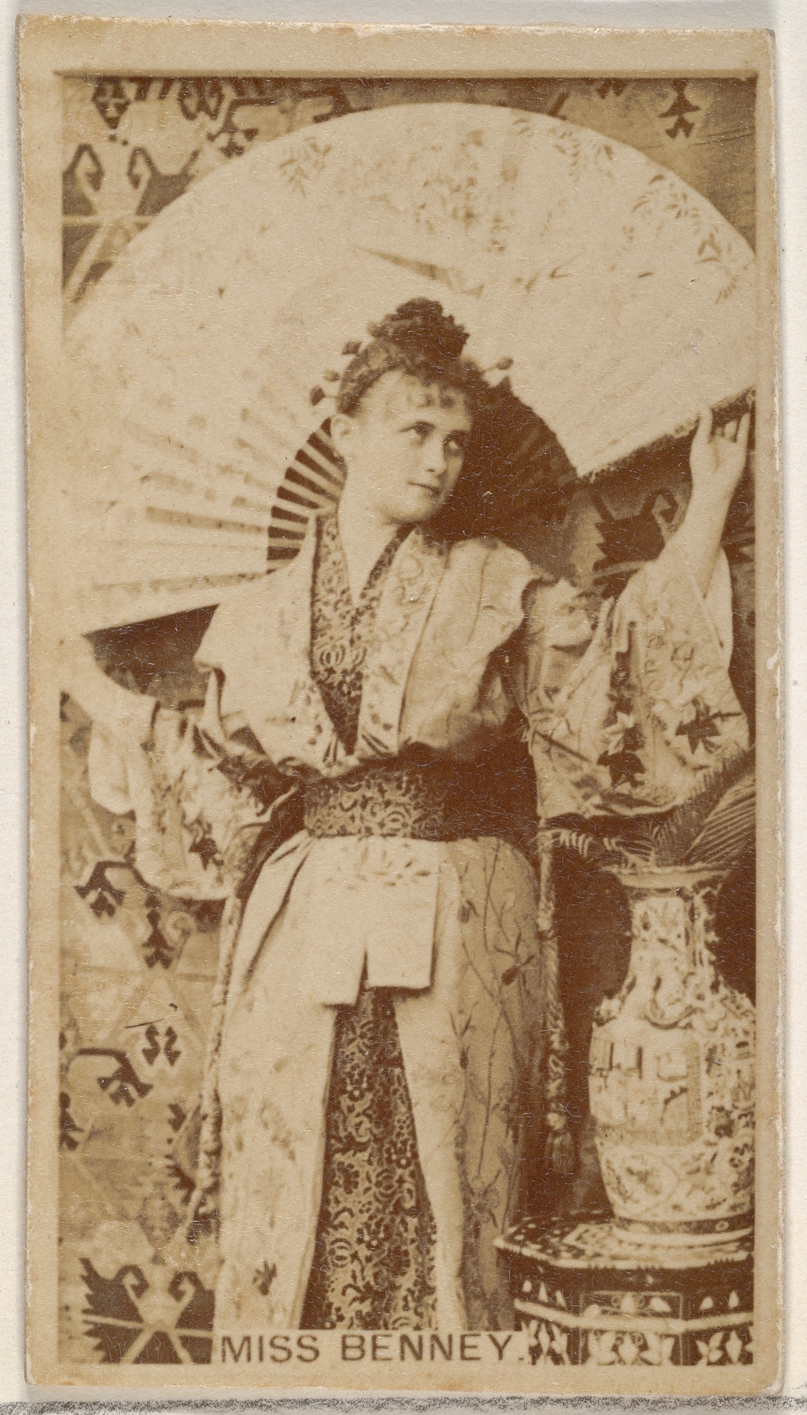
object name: photograph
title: Miss Benney, from the Actors and Actresses series (N45, Type 8) for Virginia Brights Cigarettes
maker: allen & ginter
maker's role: publisher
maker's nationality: american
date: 1888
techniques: albumen silver print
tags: fans,portraits,women,actresses